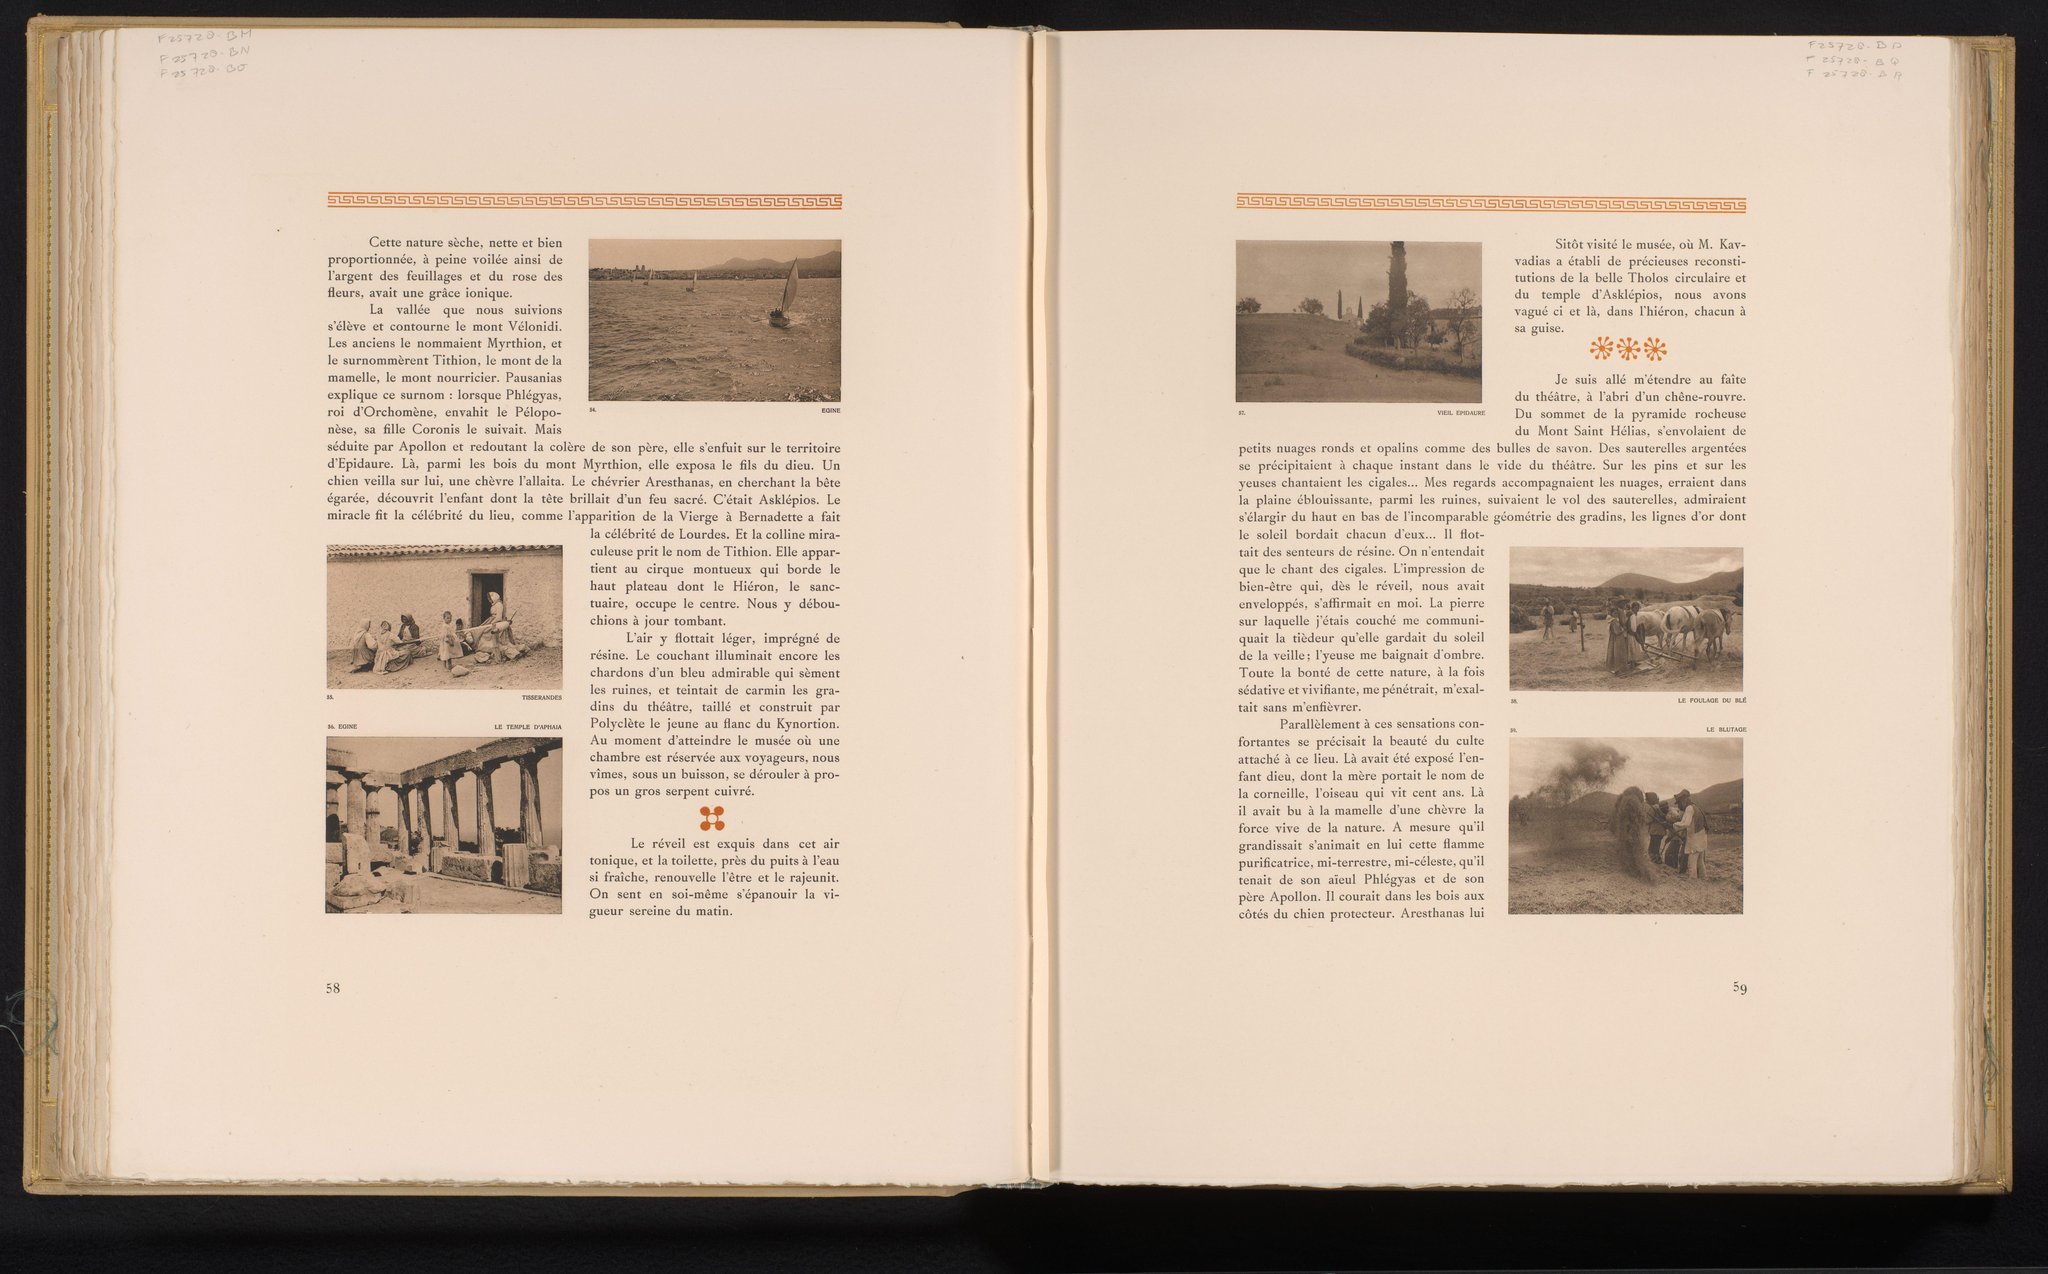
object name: photomechanical print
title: Tempel van Aphaia op Egina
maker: frédéric boissonnas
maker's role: fotograaf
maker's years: 1858-1946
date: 1905-1910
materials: paper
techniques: photograph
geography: egina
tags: temple, shrine ~ greek religion, temple of aphaea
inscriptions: number: ‘56.’